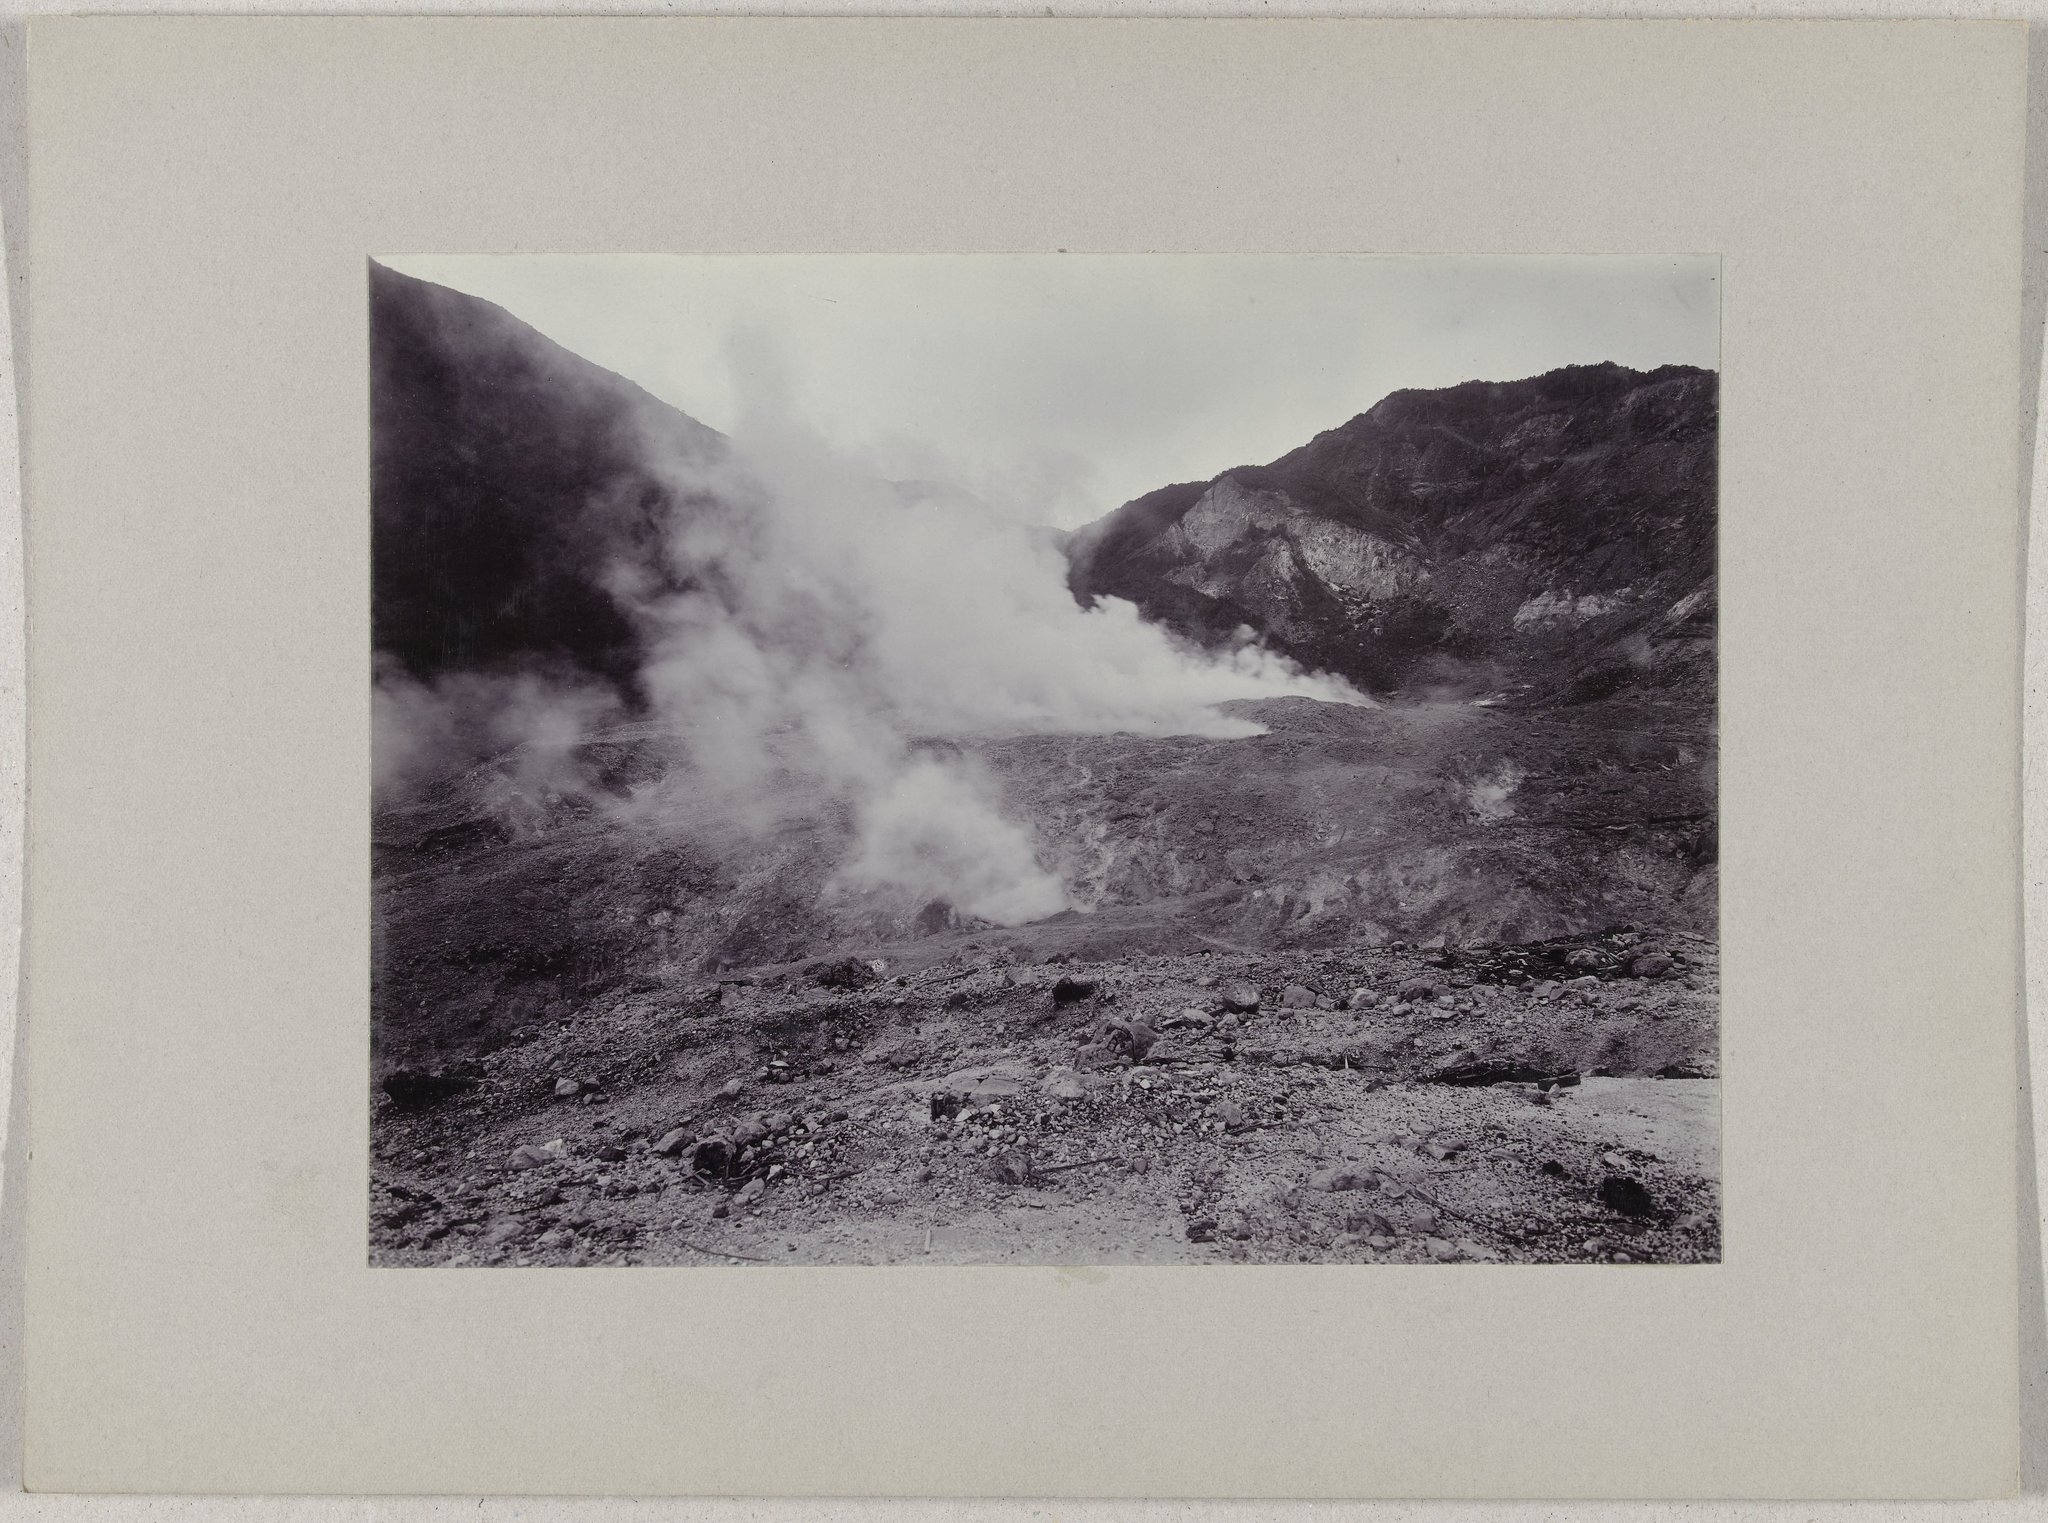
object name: photograph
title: Kawah Mas van de Papandajan bij Garoet, Nederlands-Indië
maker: onnes kurkdjian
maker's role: fotograaf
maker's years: 1851-1903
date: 1895-1915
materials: cardboard, paper, photographic support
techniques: gelatin silver print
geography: garut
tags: indonesia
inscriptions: annotation: ‘68. Papandajan bij Garoet’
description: Kawah Mas van de Papandajan bij Garoet, Nederlands-Indië